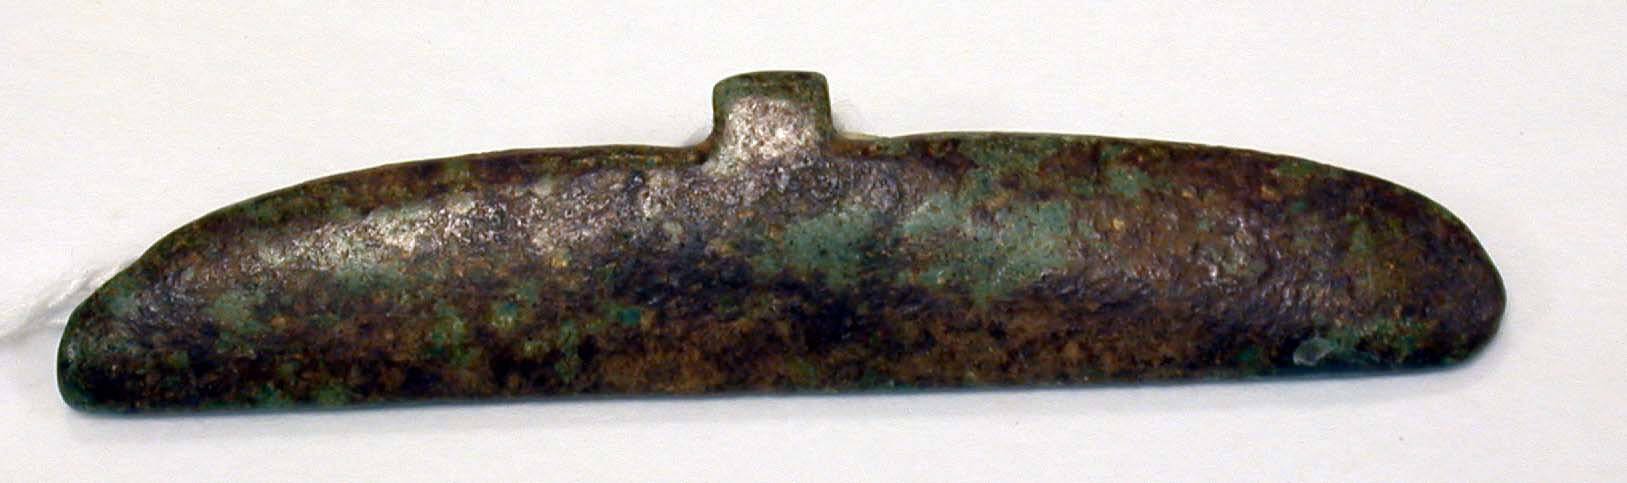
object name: pendant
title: Winged Pendant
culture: tairona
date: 1501-1600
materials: stone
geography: colombia